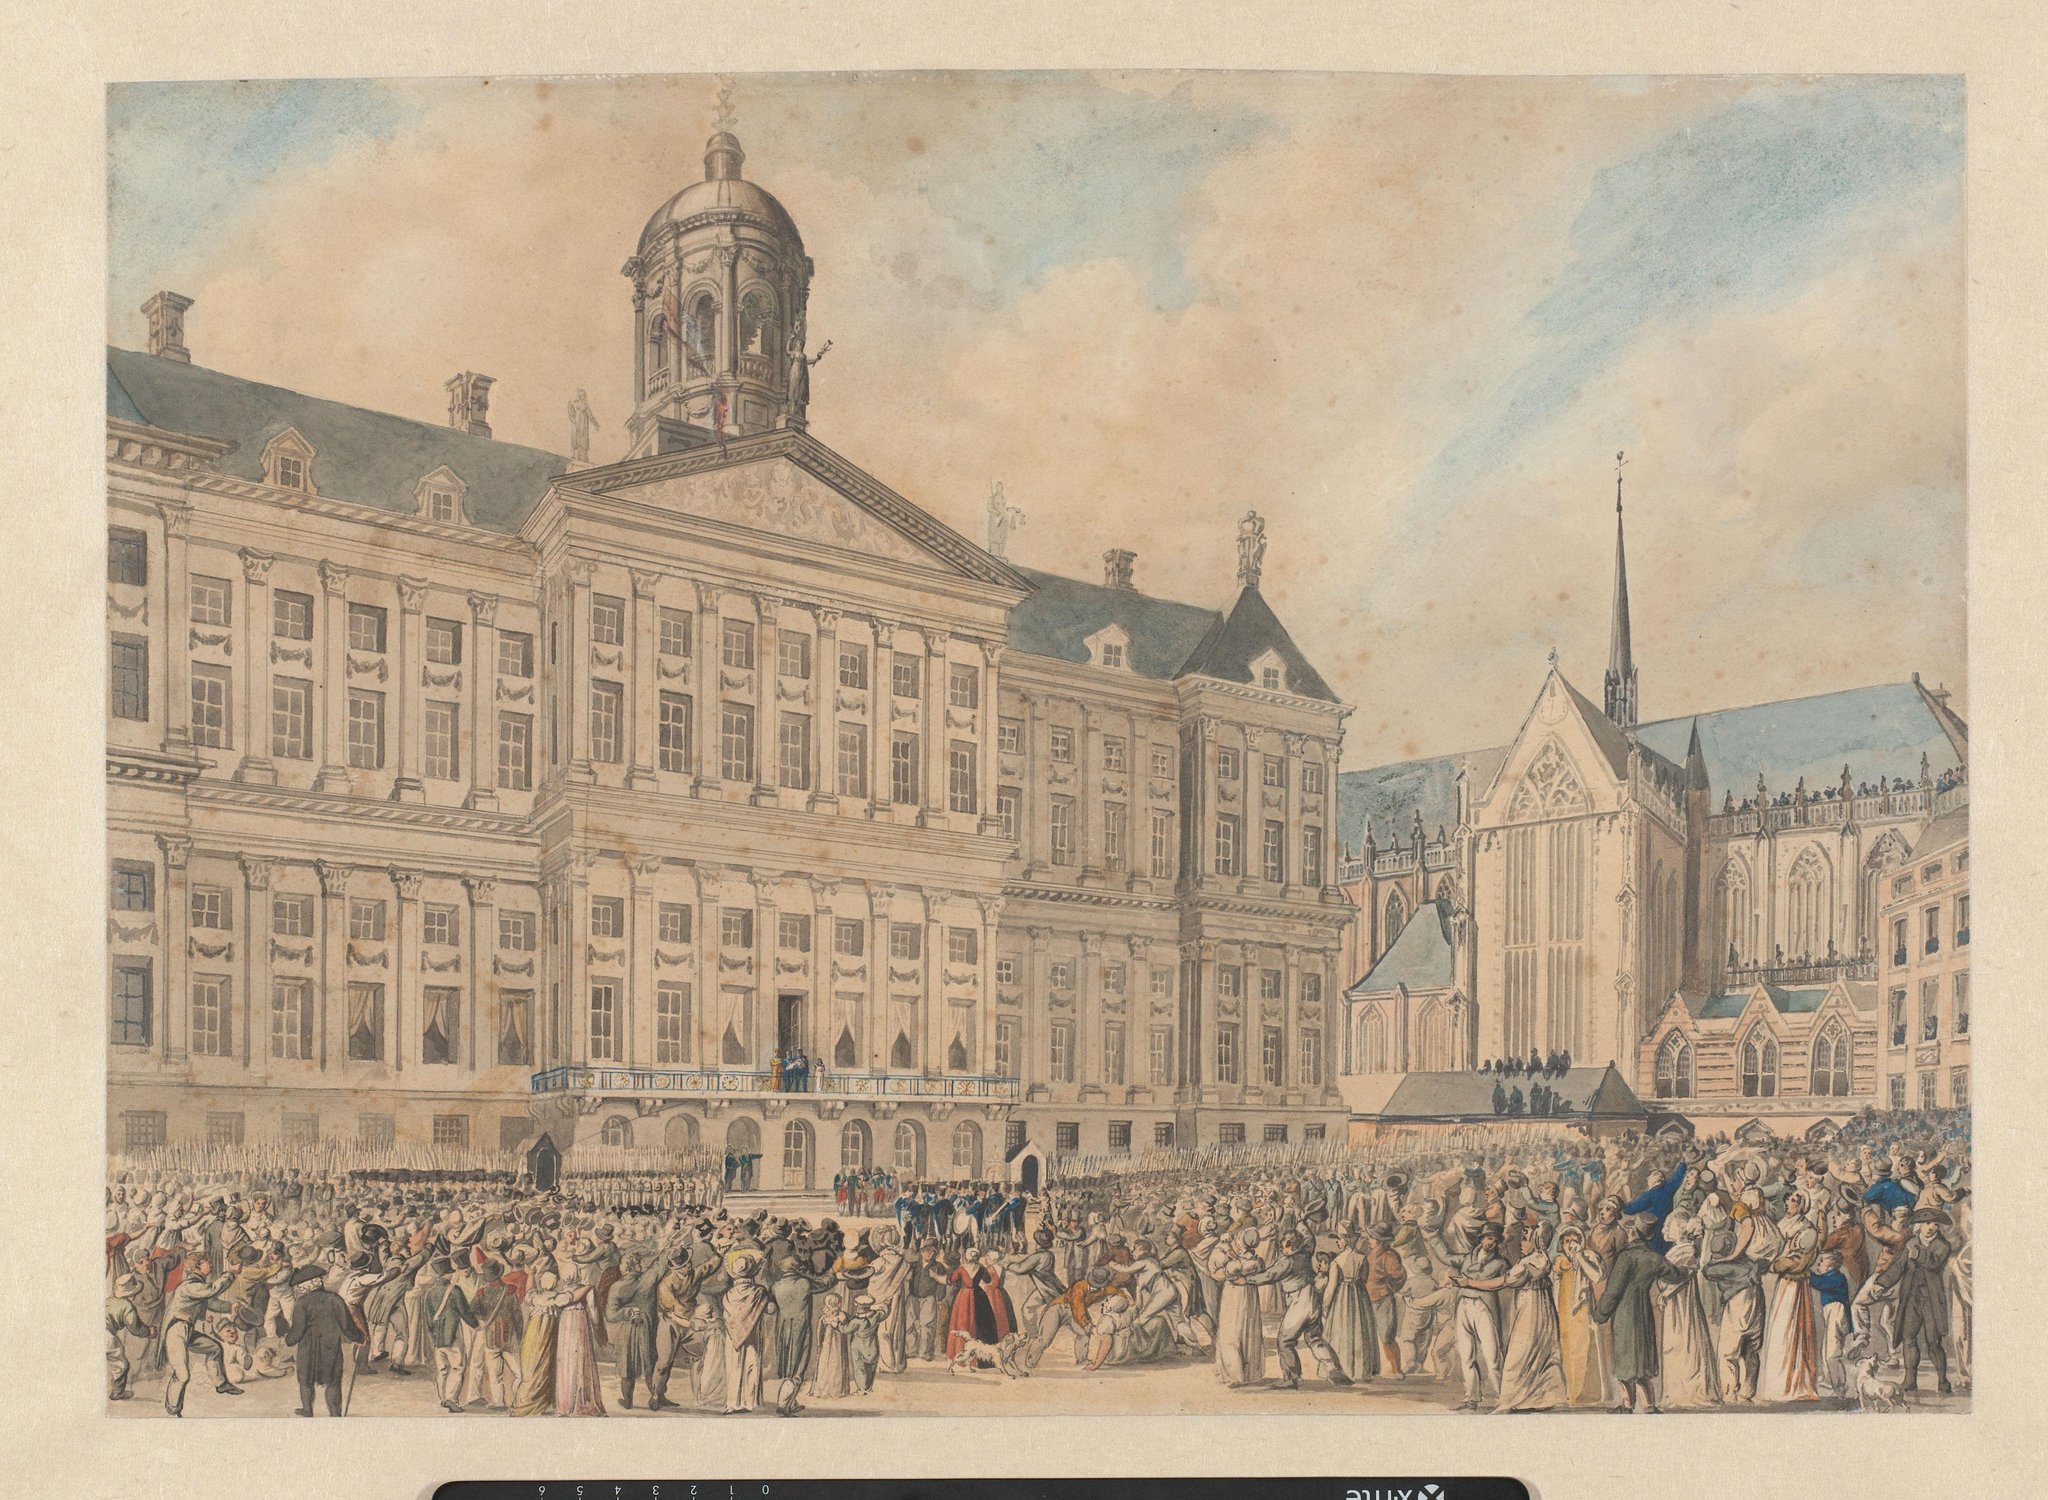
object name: watercolor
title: De koninklijke familie op het balkon van het Paleis op de Dam, 1822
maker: Anonymous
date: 1800-1900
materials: ink, paper, pencil, watercolor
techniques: brush, pen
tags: brussels, square, place, circus, etc., the new-born child shown to the father, court ceremonial, court etiquette, historical persons, historical events and situations, royal palace of amsterdam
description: De koninklijke familie met de kroonprins (later koning Willem II) en de pasgeboren prins Ernst Casimir op het balkon van het Paleis op de Dam, 1822. Ontwerp voor een prent.